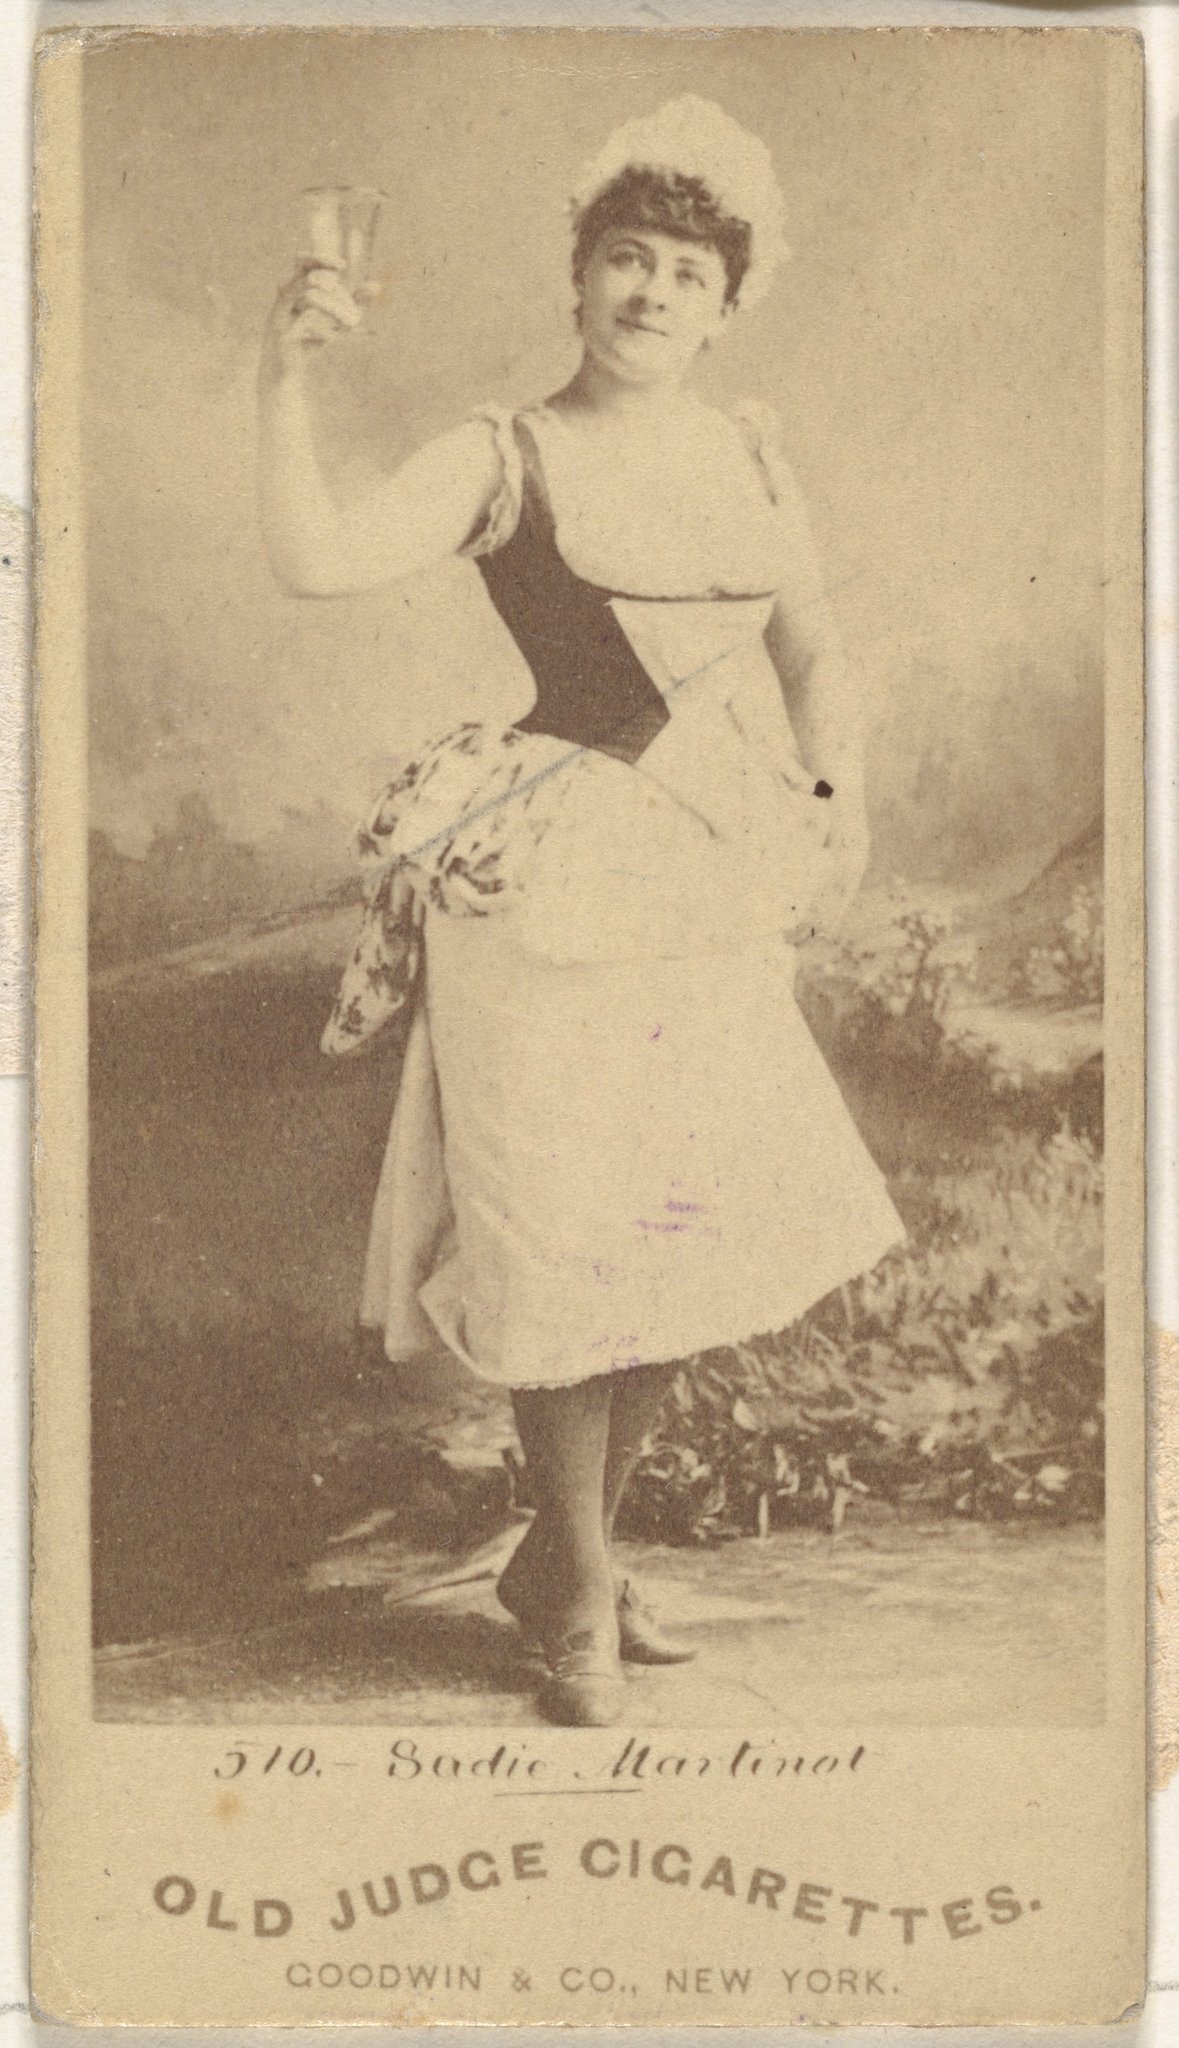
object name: photograph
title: Sadie Martinot, from the Actors and Actresses series (N171) for Old Judge Cigarettes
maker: goodwin & company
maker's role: publisher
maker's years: 1850-1950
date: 1886-1890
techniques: albumen silver print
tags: portraits,women,actresses